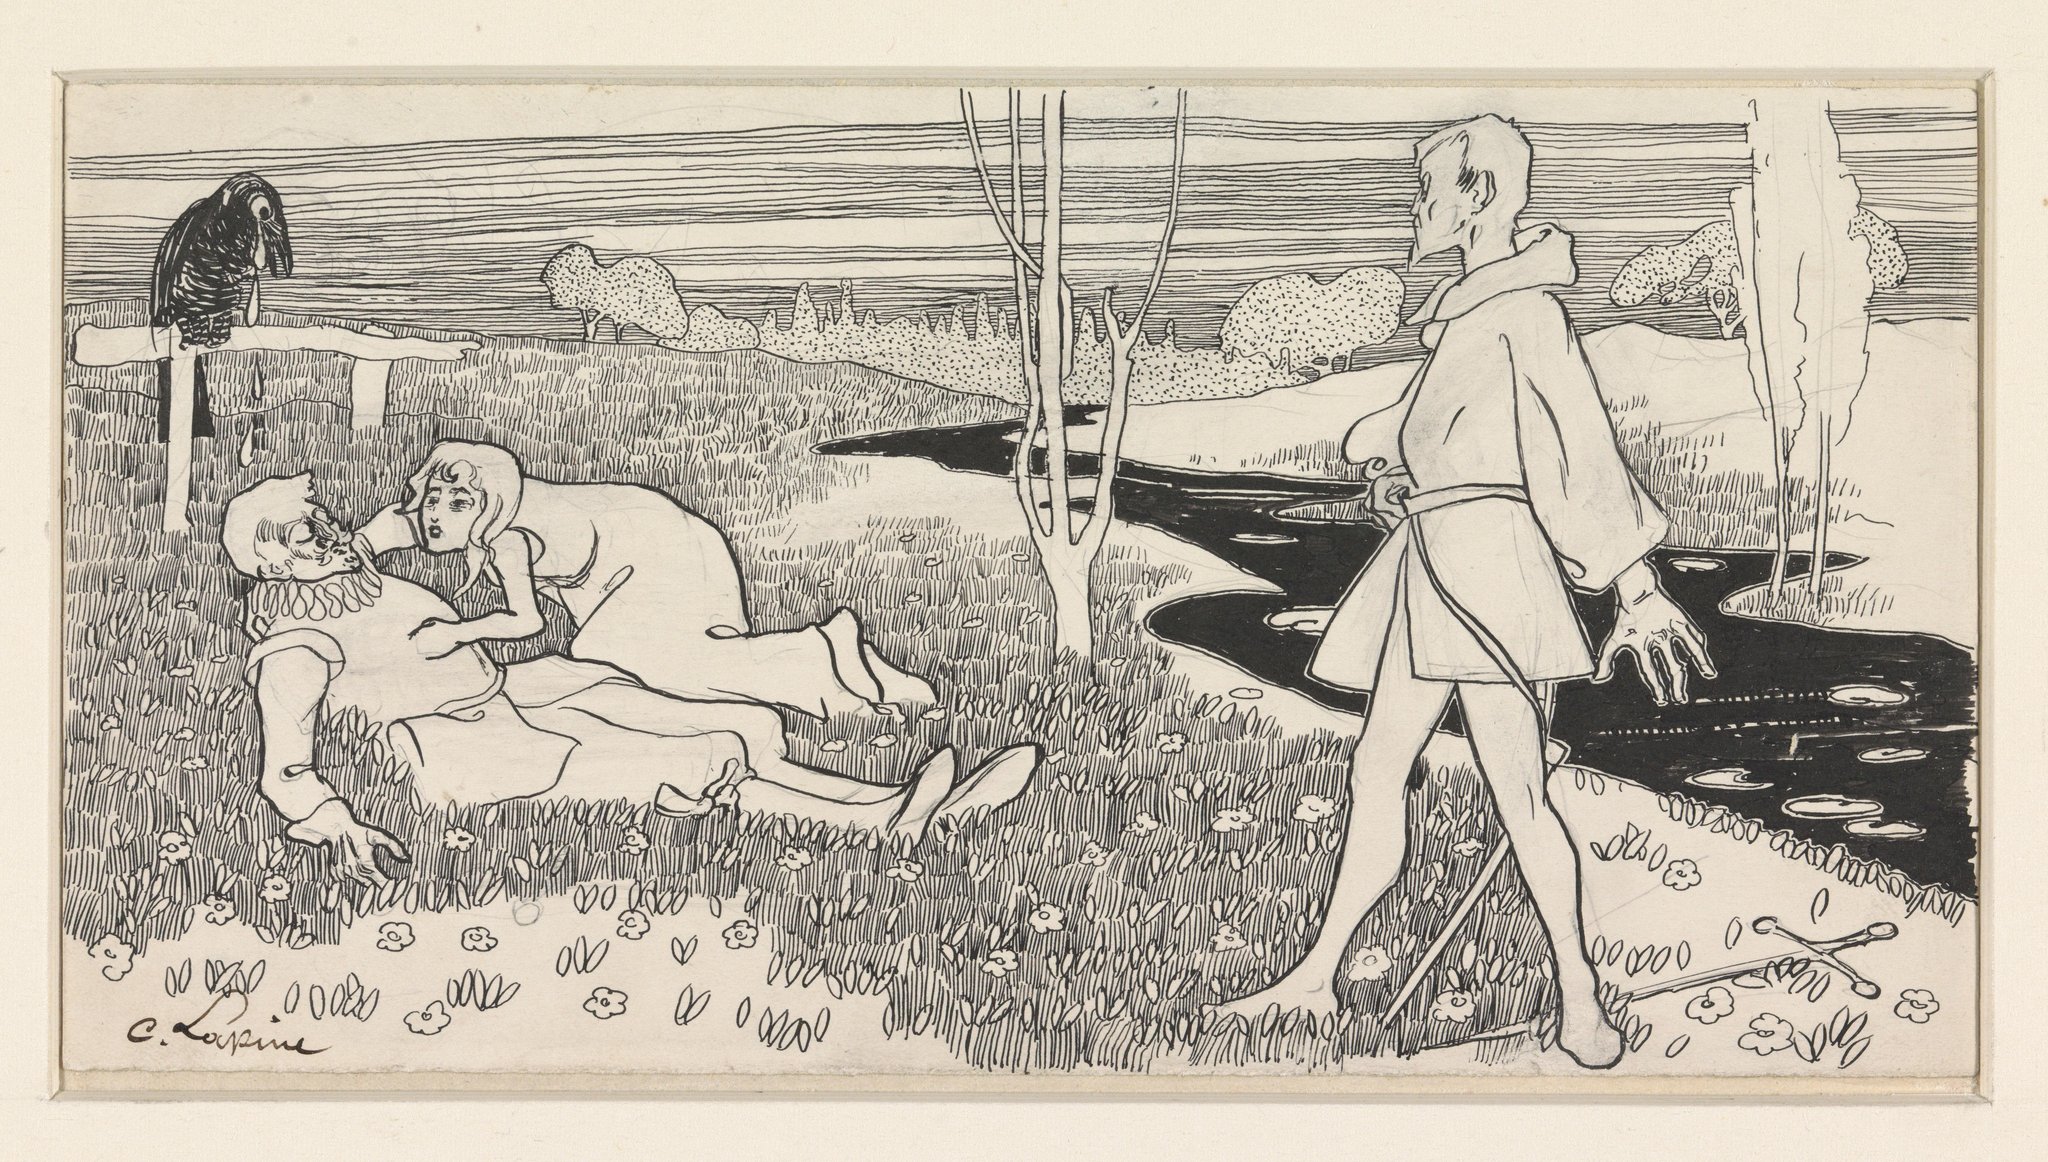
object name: drawing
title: Vrouw geknield bij de verliezer van een duel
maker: c. lapine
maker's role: draughtsman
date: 1895-1900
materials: ink, paper, pencil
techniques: brush, pen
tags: violent death, being killed; being mishandled and maltreated; seeking death (+ death in a duel)